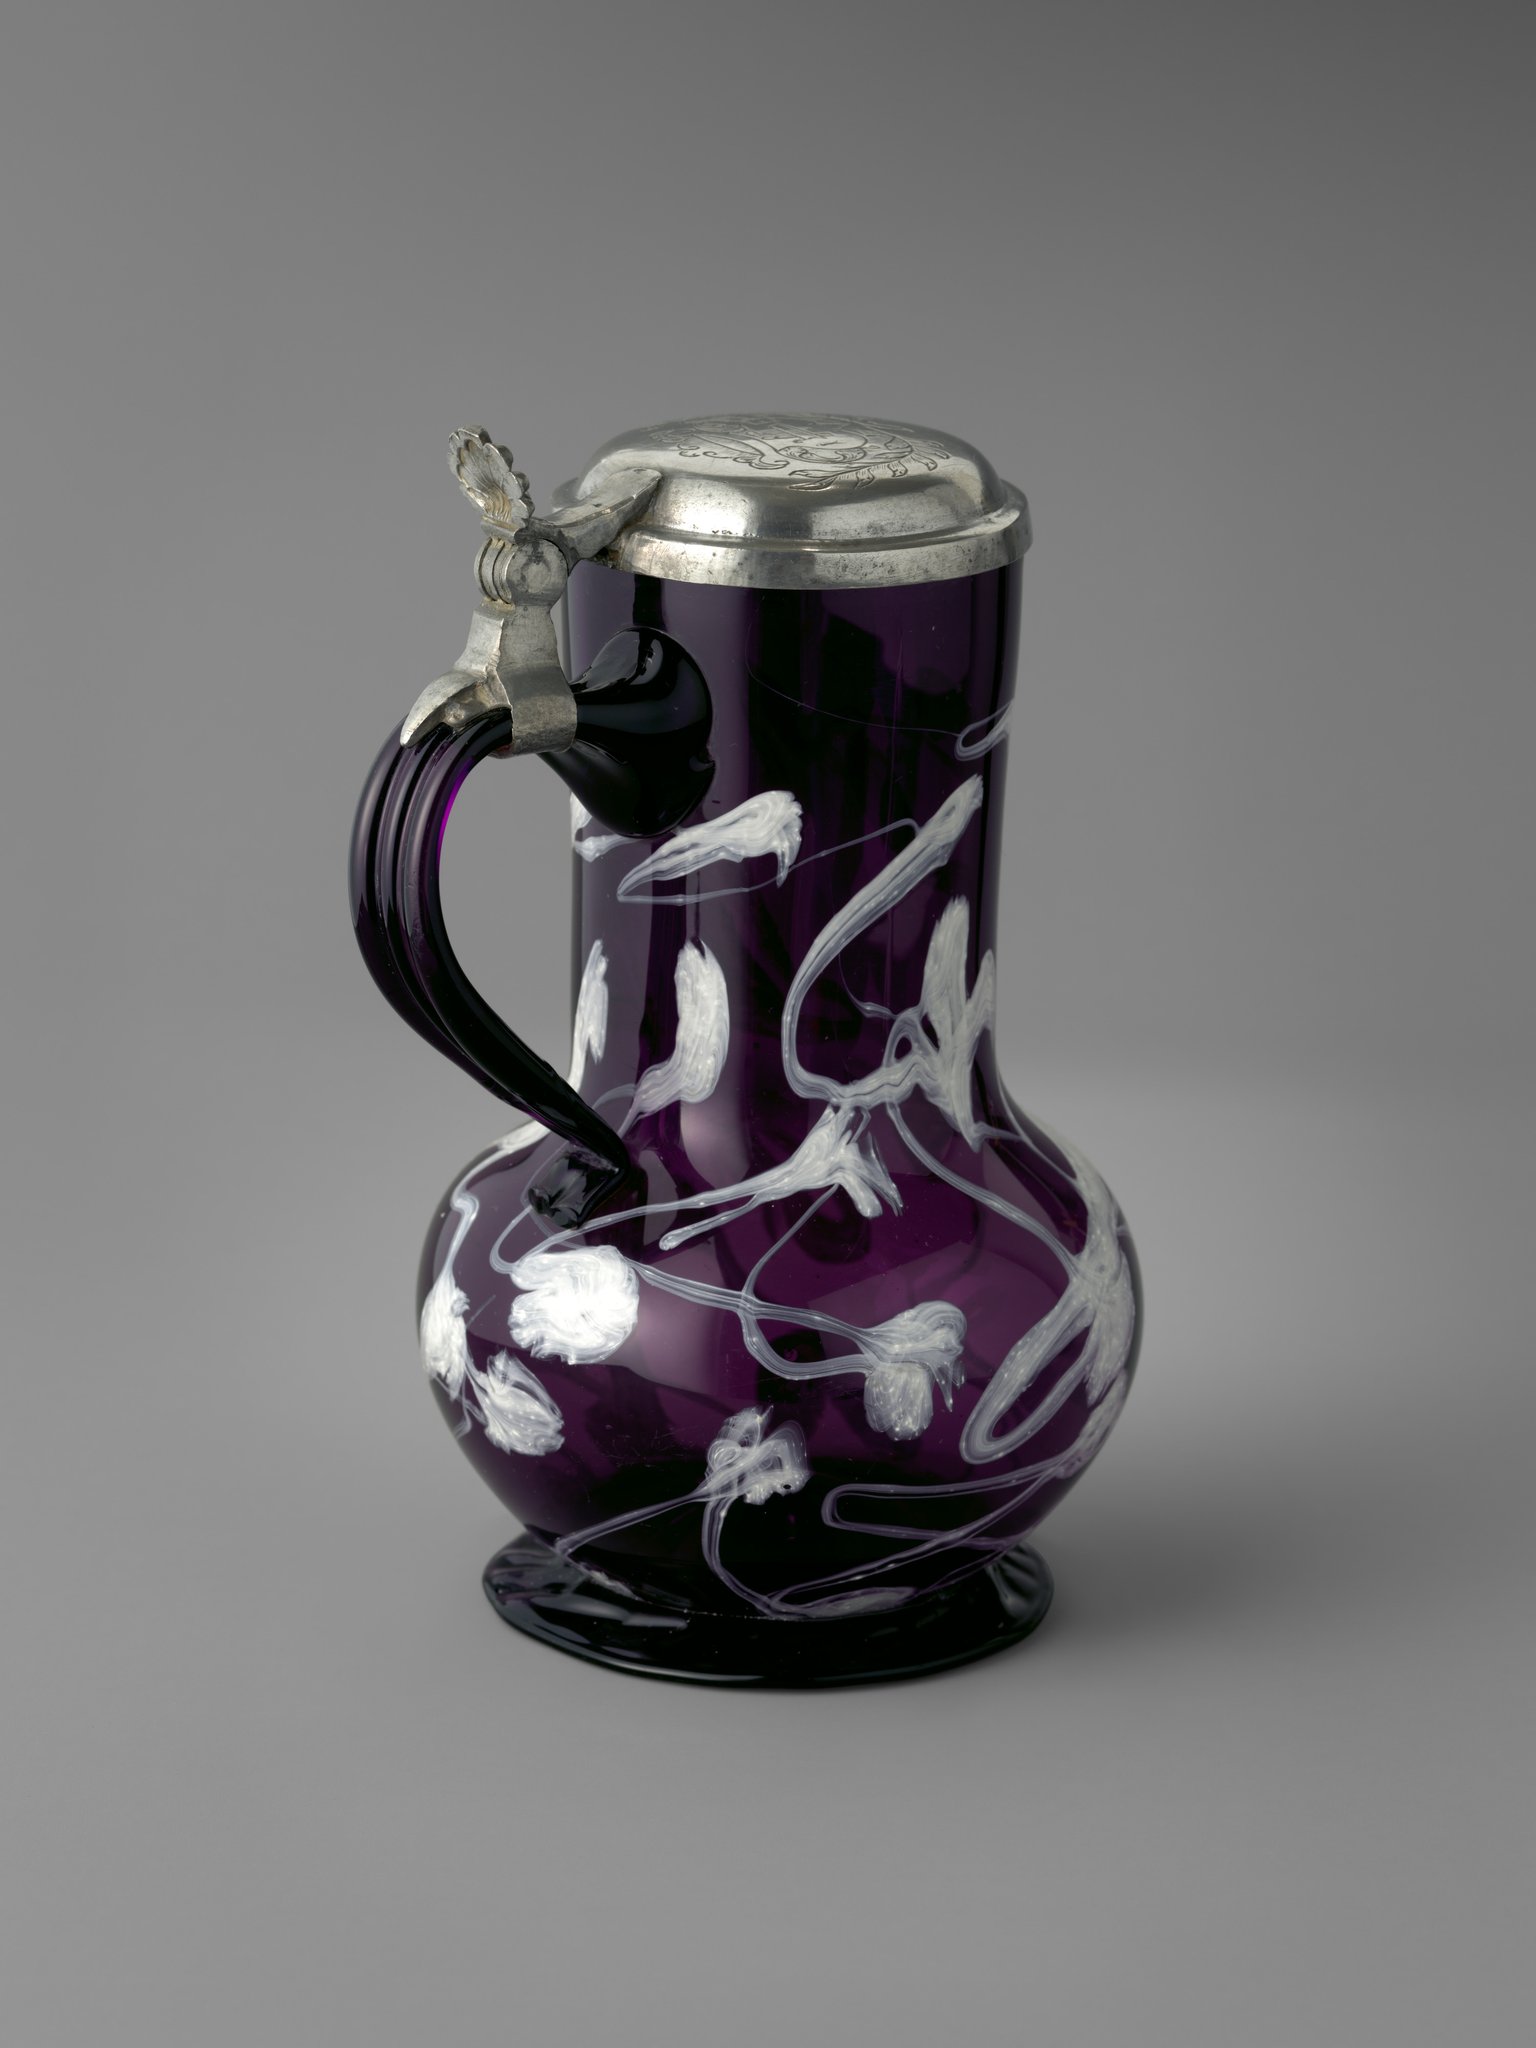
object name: tankard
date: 1716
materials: glass, pewter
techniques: glassblowing